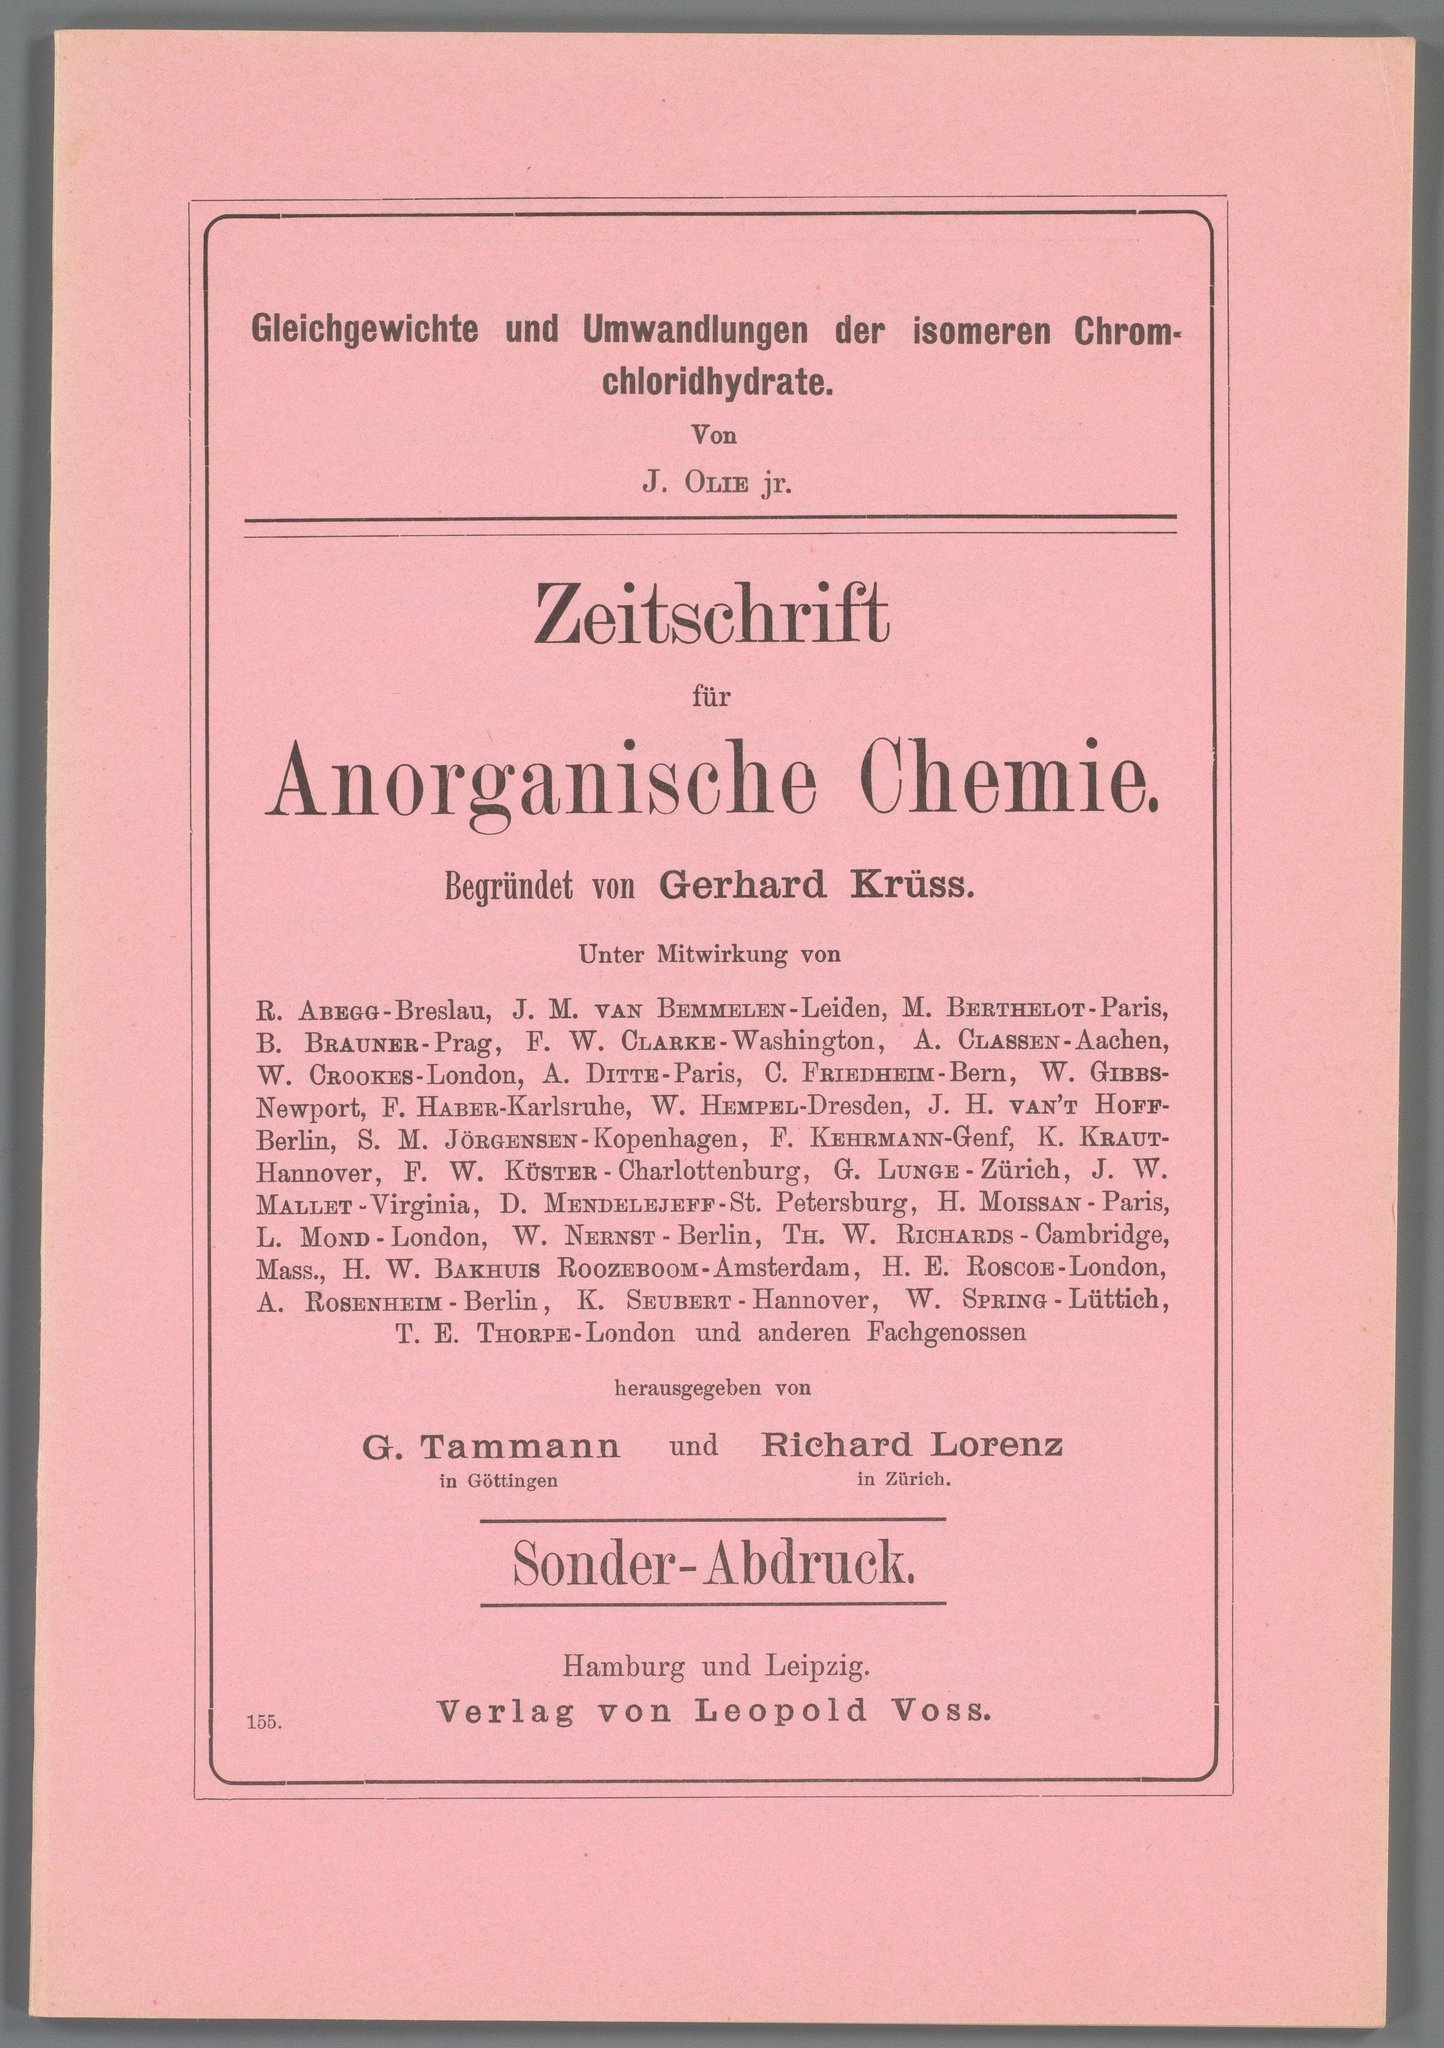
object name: offprint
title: Gleichgewichte und Umwandlungen der isomeren Chromchloridhydrate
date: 1906-1908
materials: paper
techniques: letterpress printing, printing block, engraving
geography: leipzig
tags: printed matter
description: Overdruk uit het 'Zeitschrift für Anorganische Chemie'.